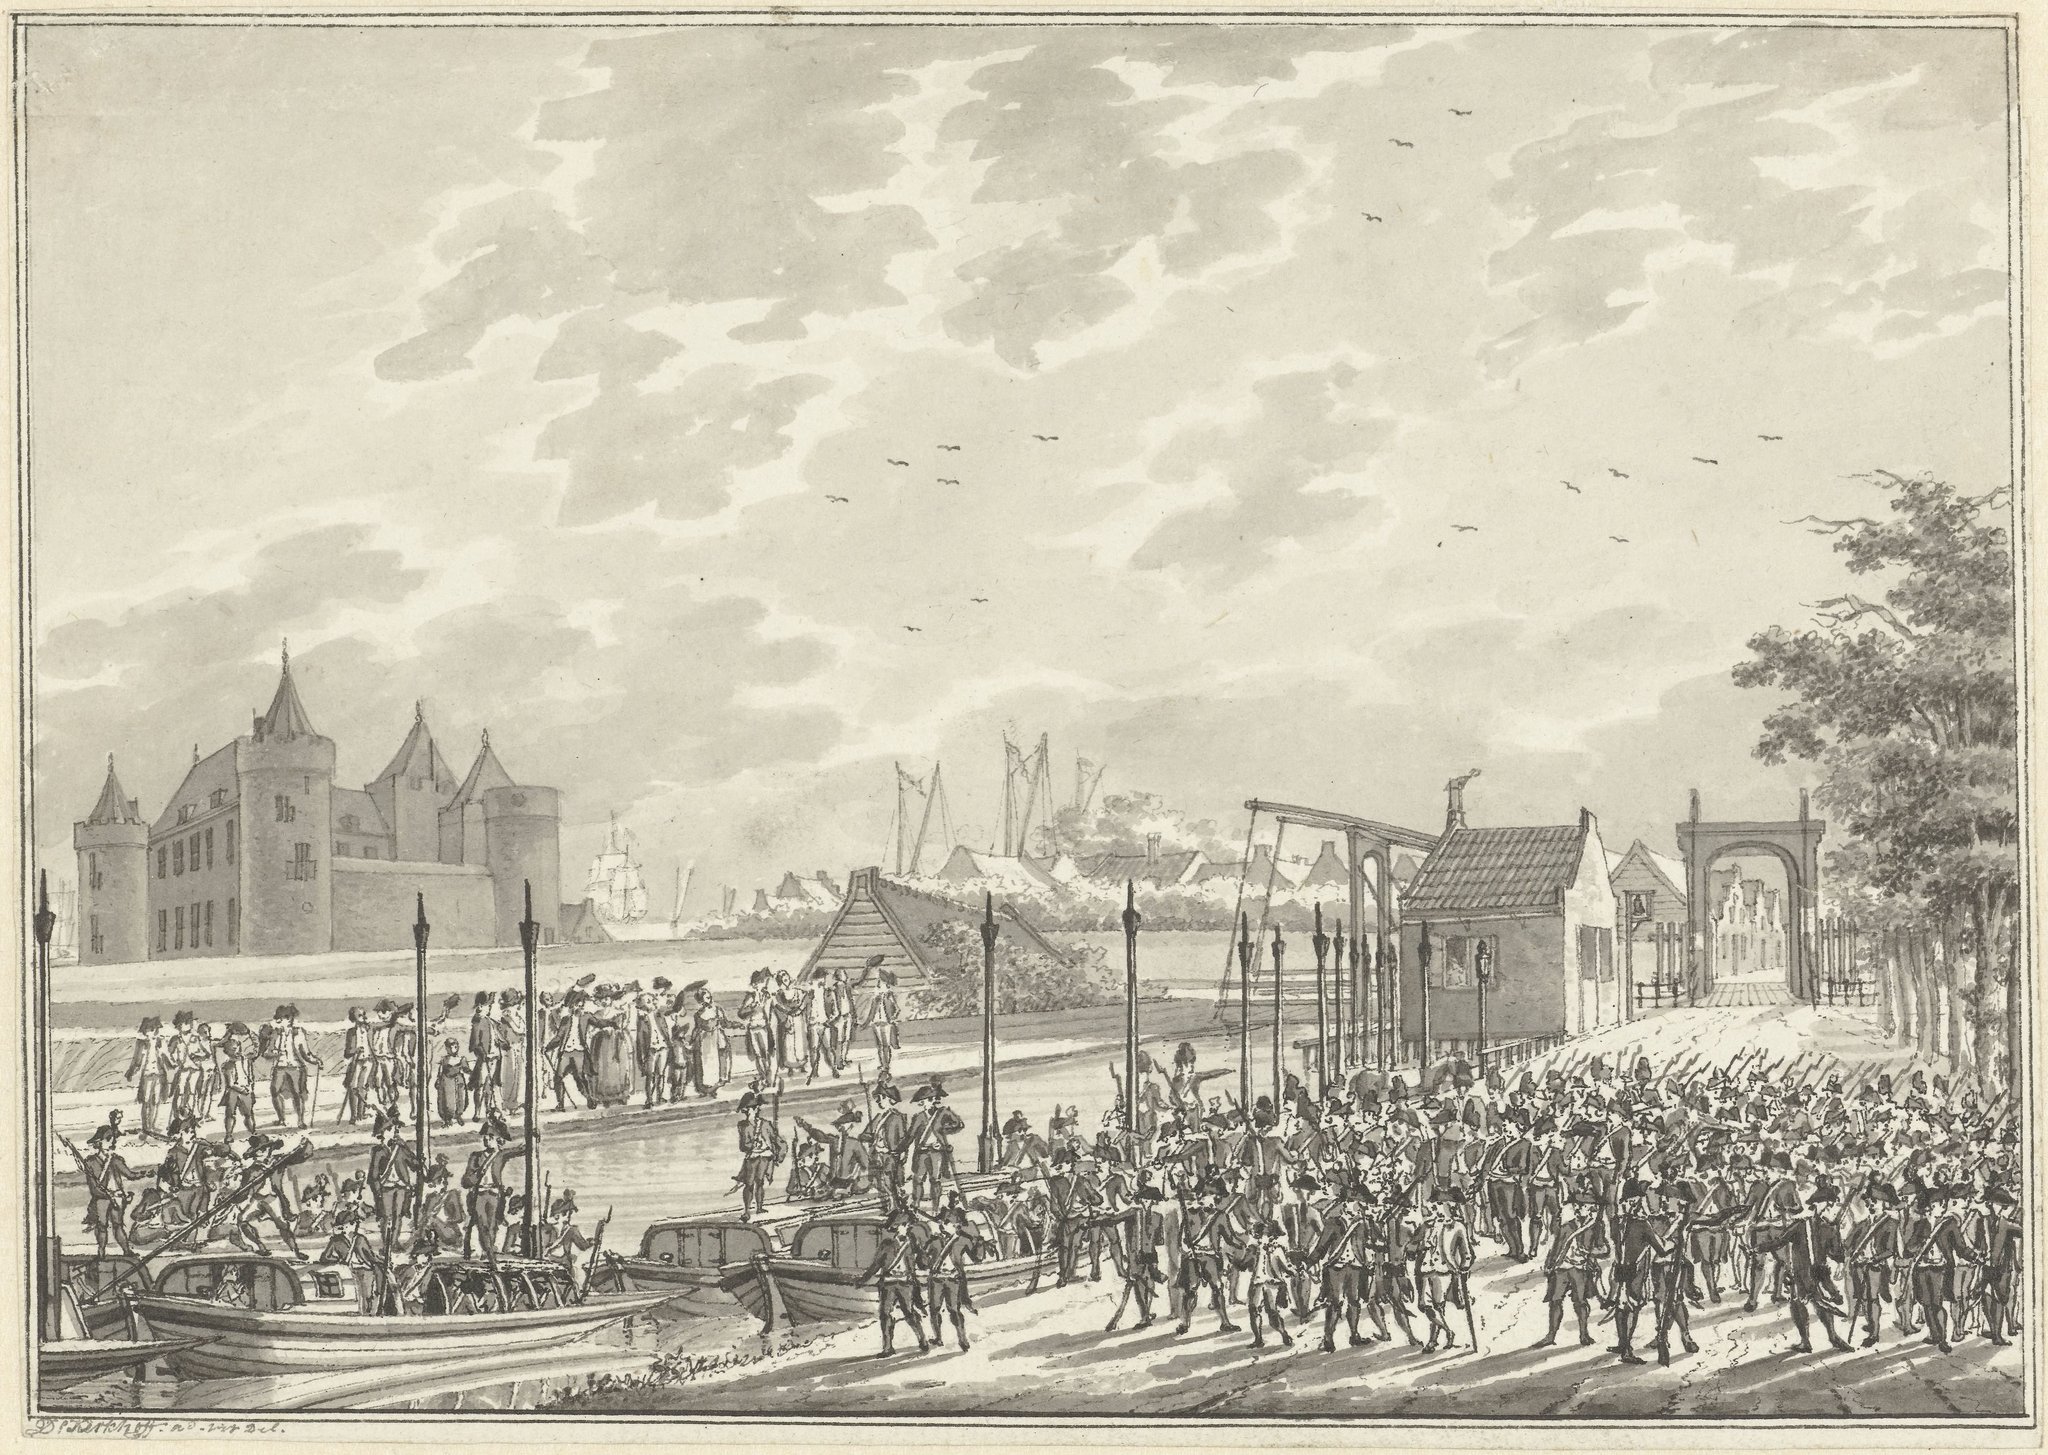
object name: design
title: Aankomst van de gewapende Amsterdamse burgers in Muiden, 1787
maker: daniël kerkhoff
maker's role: draughtsman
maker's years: 1766-1821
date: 1787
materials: ink, paper, pencil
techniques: brush, pen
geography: muiden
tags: patriots (1780-1795)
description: Aankomst van de boten met gewapende Amsterdamse burgers te Muiden, 7 juni 1787. Op de achtergrond het Muiderslot.